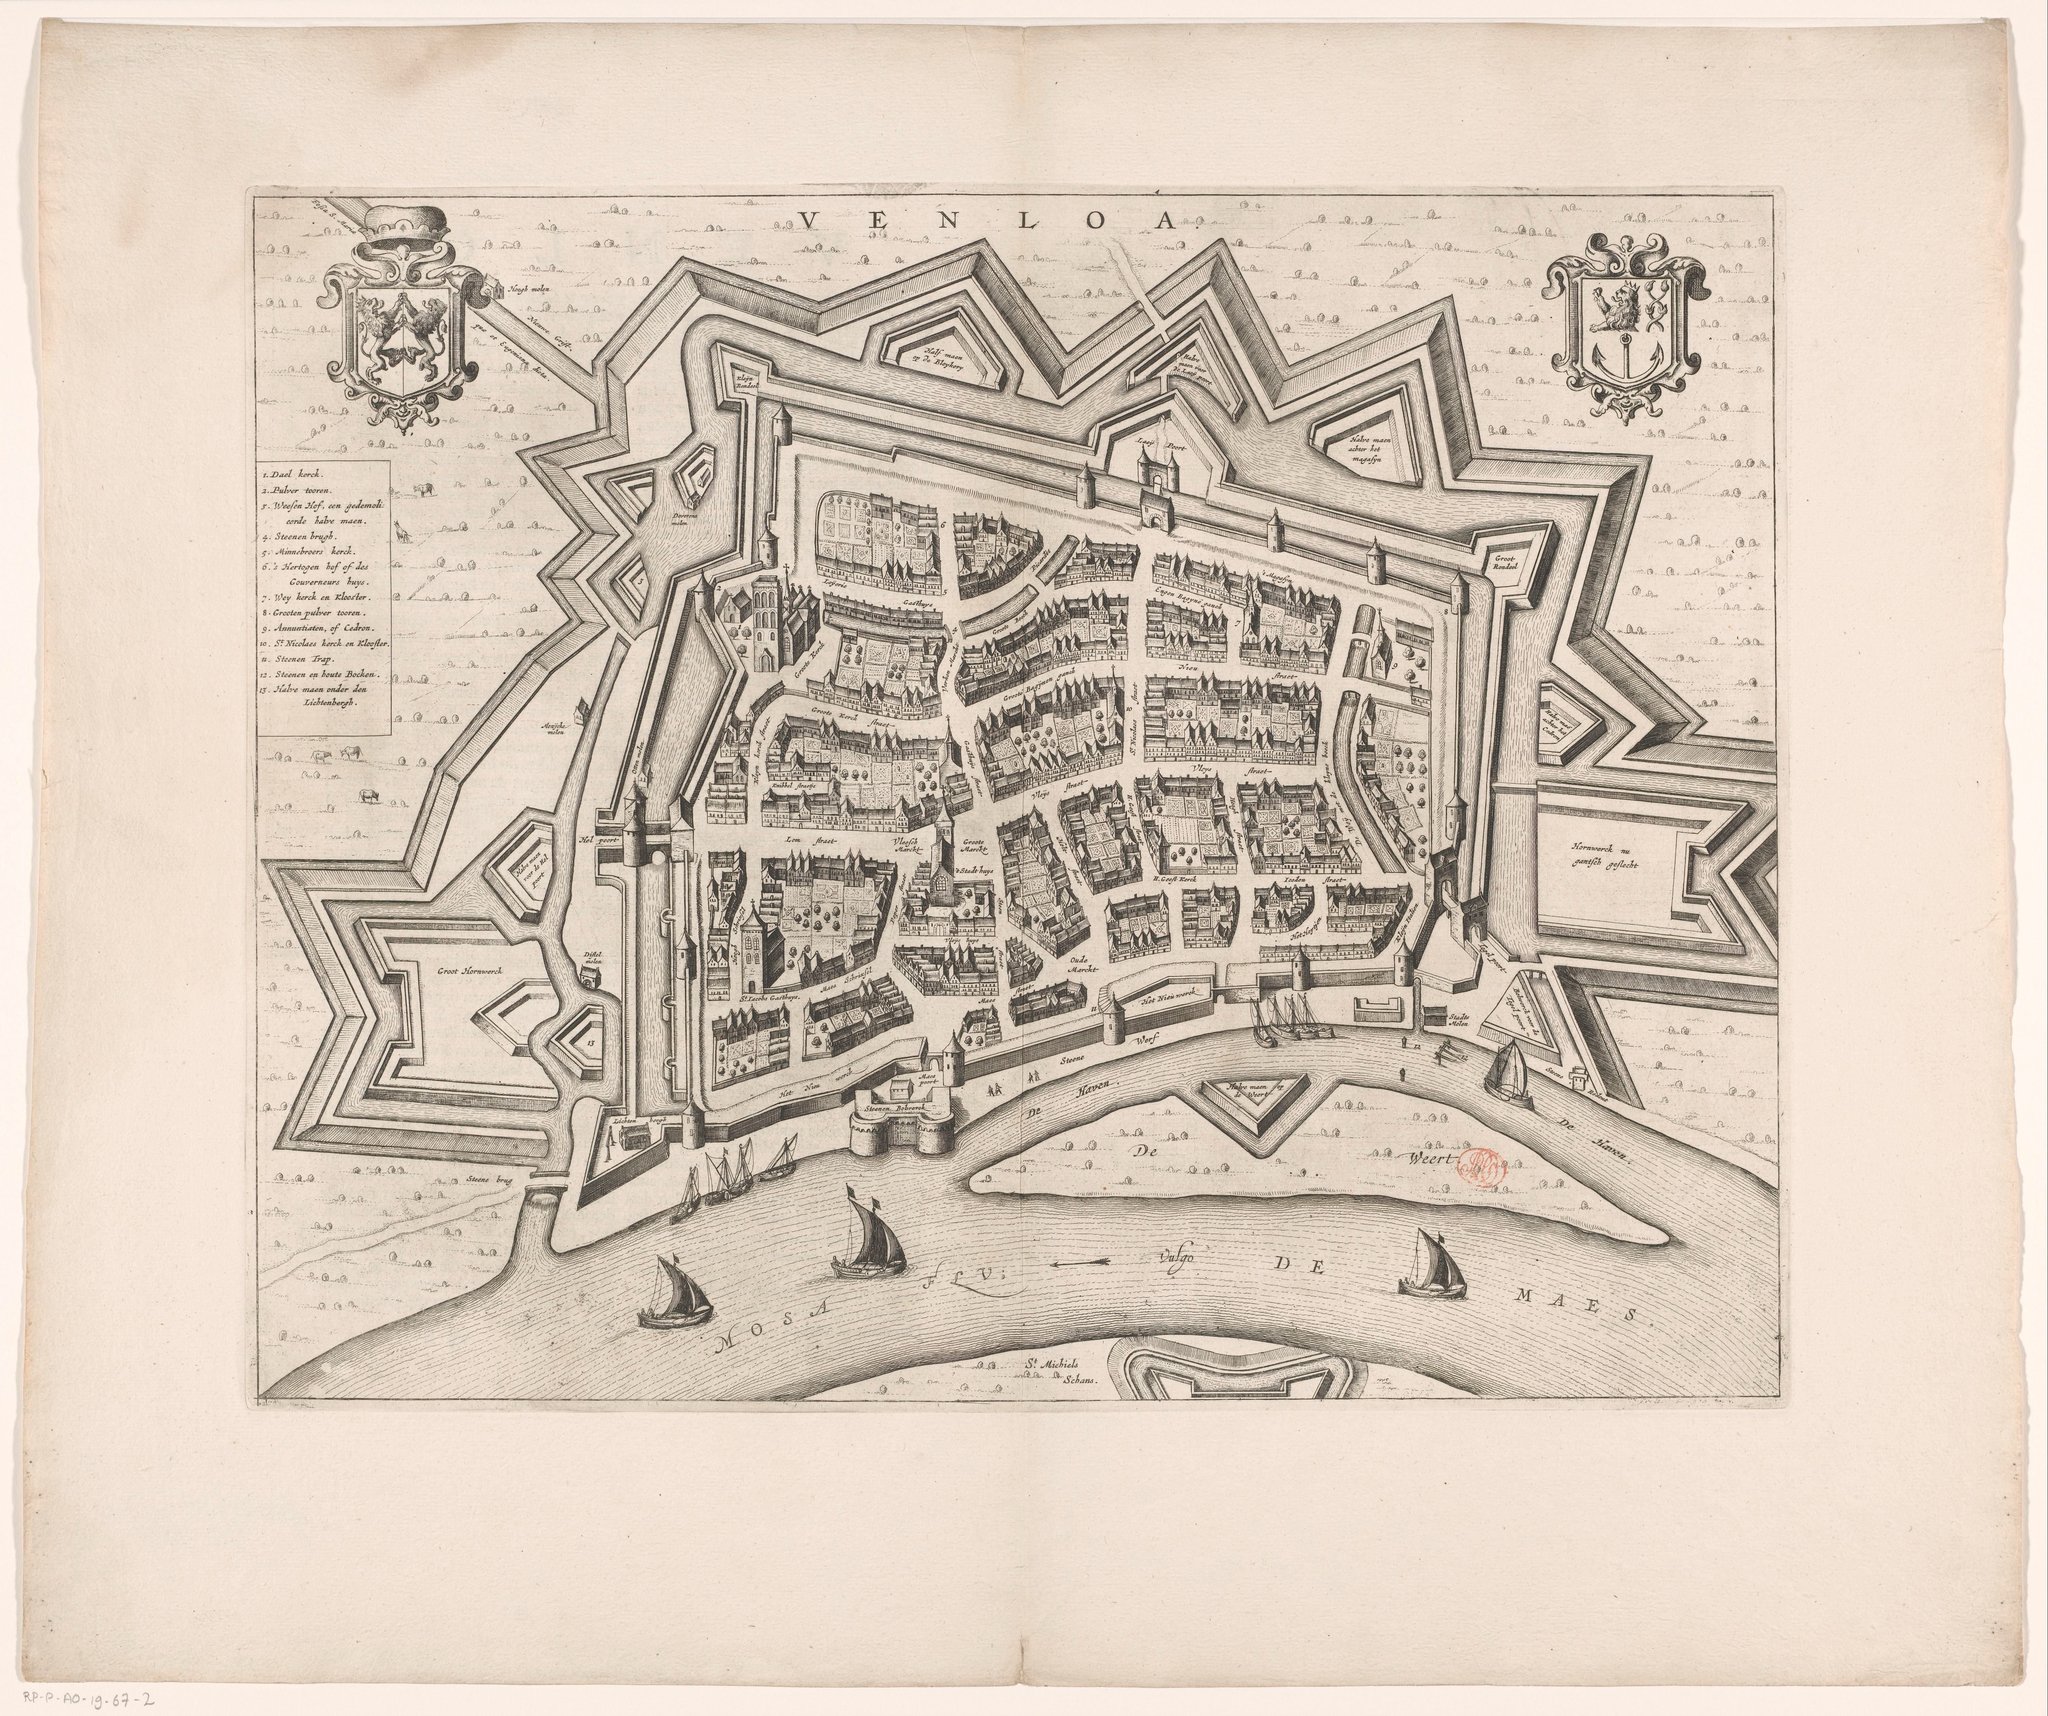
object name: print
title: Plattegrond van Venlo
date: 1652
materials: paper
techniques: engraving, etching, letterpress printing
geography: amsterdam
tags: coat of arms (as symbol of the state, etc.) (+ city; municipal), fortified city, maps of cities, coat of arms (as symbol of the state, etc.) (+ province; provincial)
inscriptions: collector's mark: Lugt 195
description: Plattegrond van Venlo met gebouwen in vogelvluchtperspectief. Boven, in het midden, de titel. Linksboven het wapen van het hertogdom Gelre, rechtsboven het wapen van Venlo. Onder het wapen van Gelre een kader met legenda 1-13. Met Nederlandse tekst op verso.